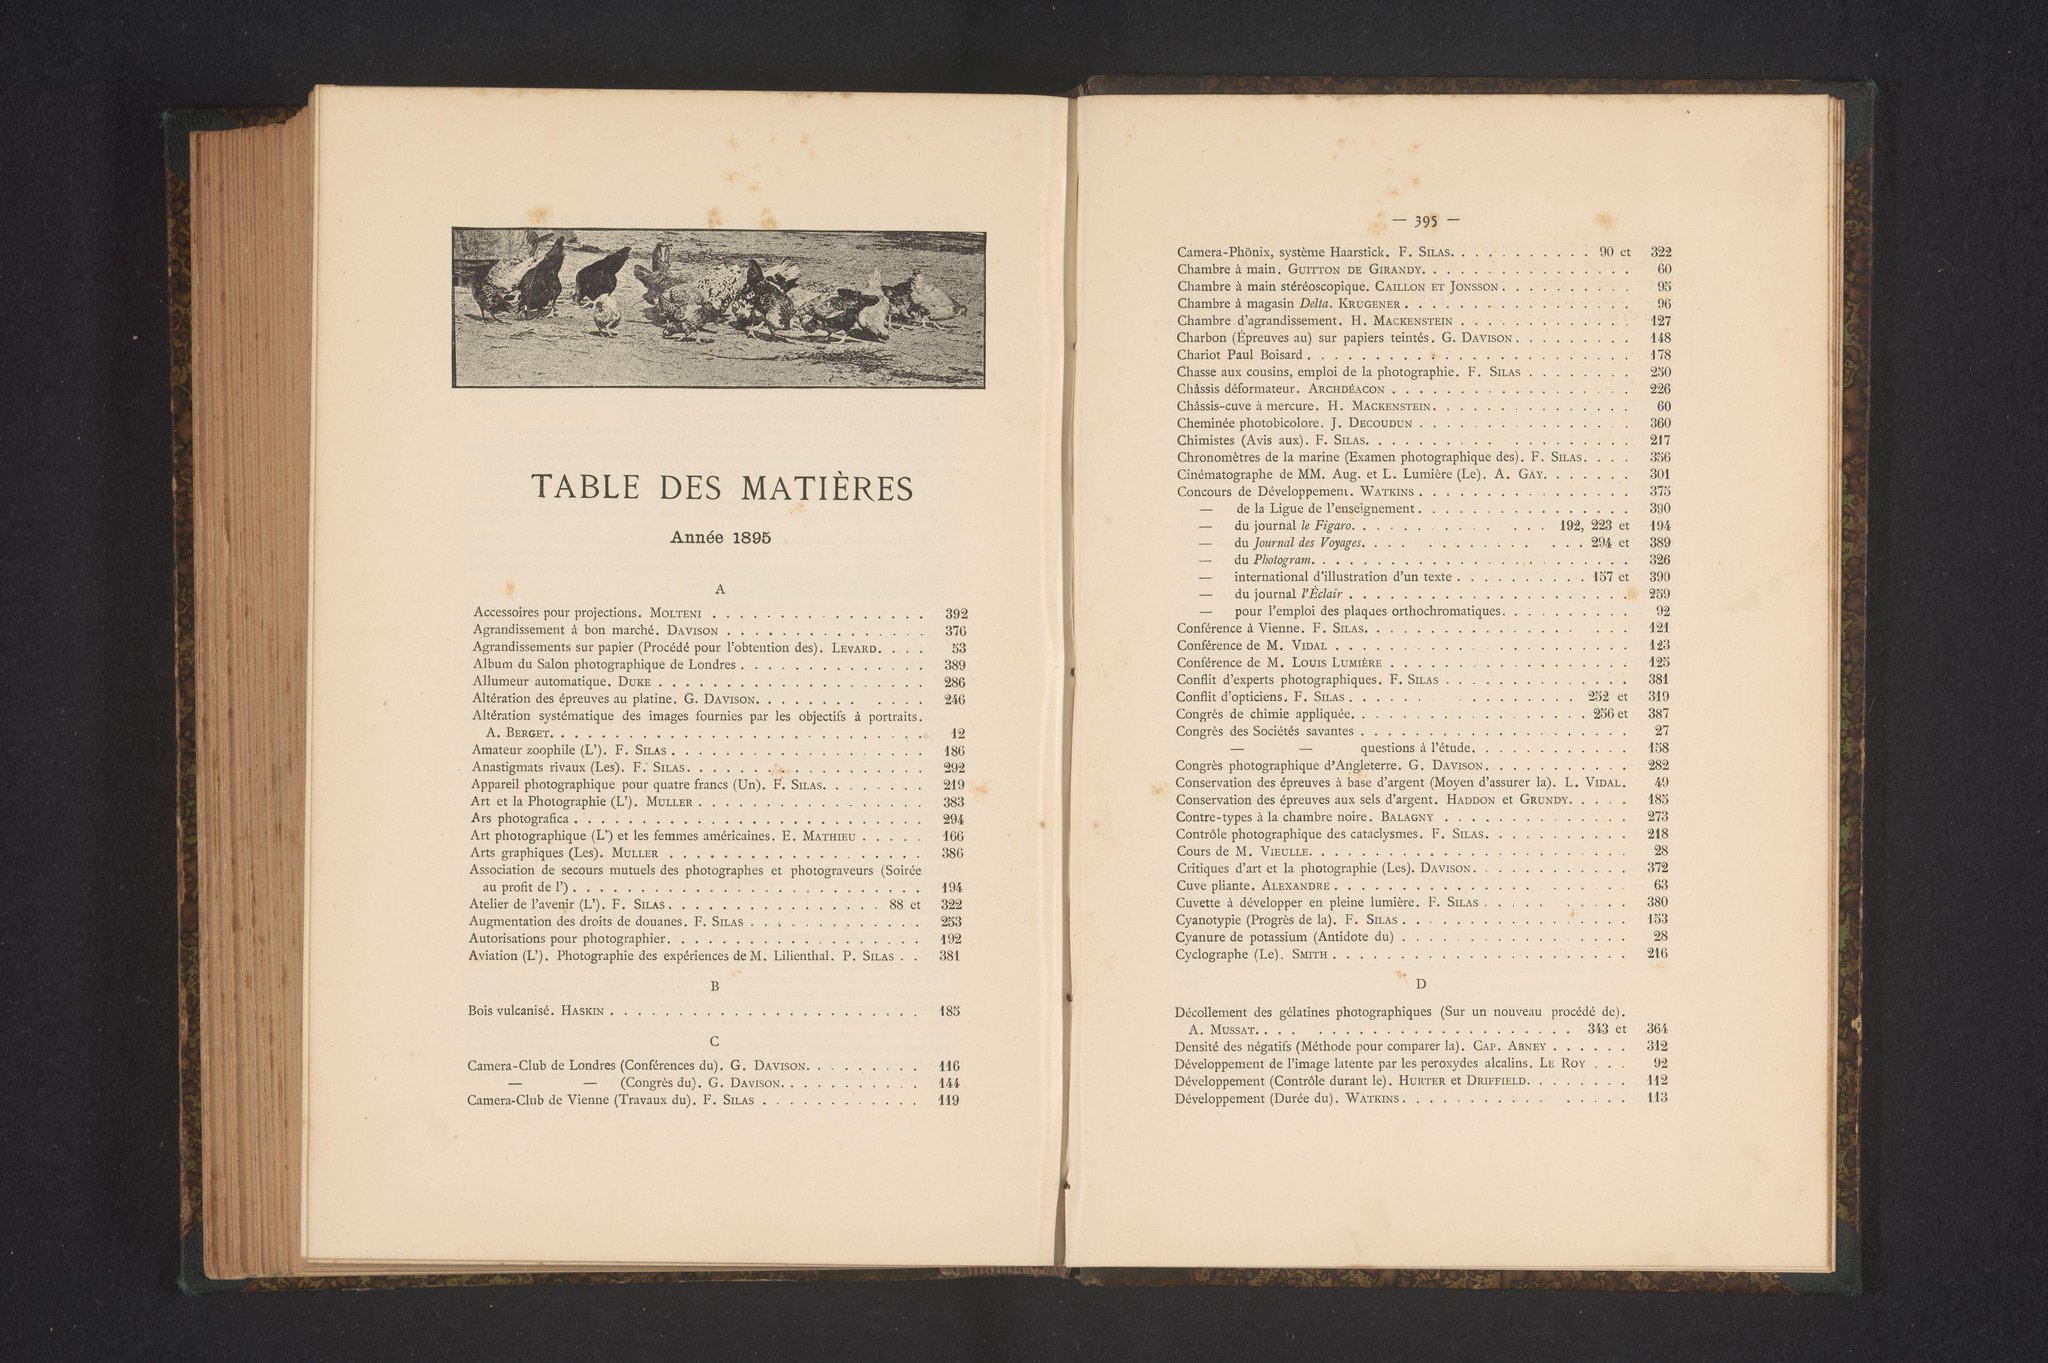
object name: page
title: Kippen op een erf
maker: Anonymous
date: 1890-1895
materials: paper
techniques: photograph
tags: fowl (cock, hen, chicken, etc.), courtyard